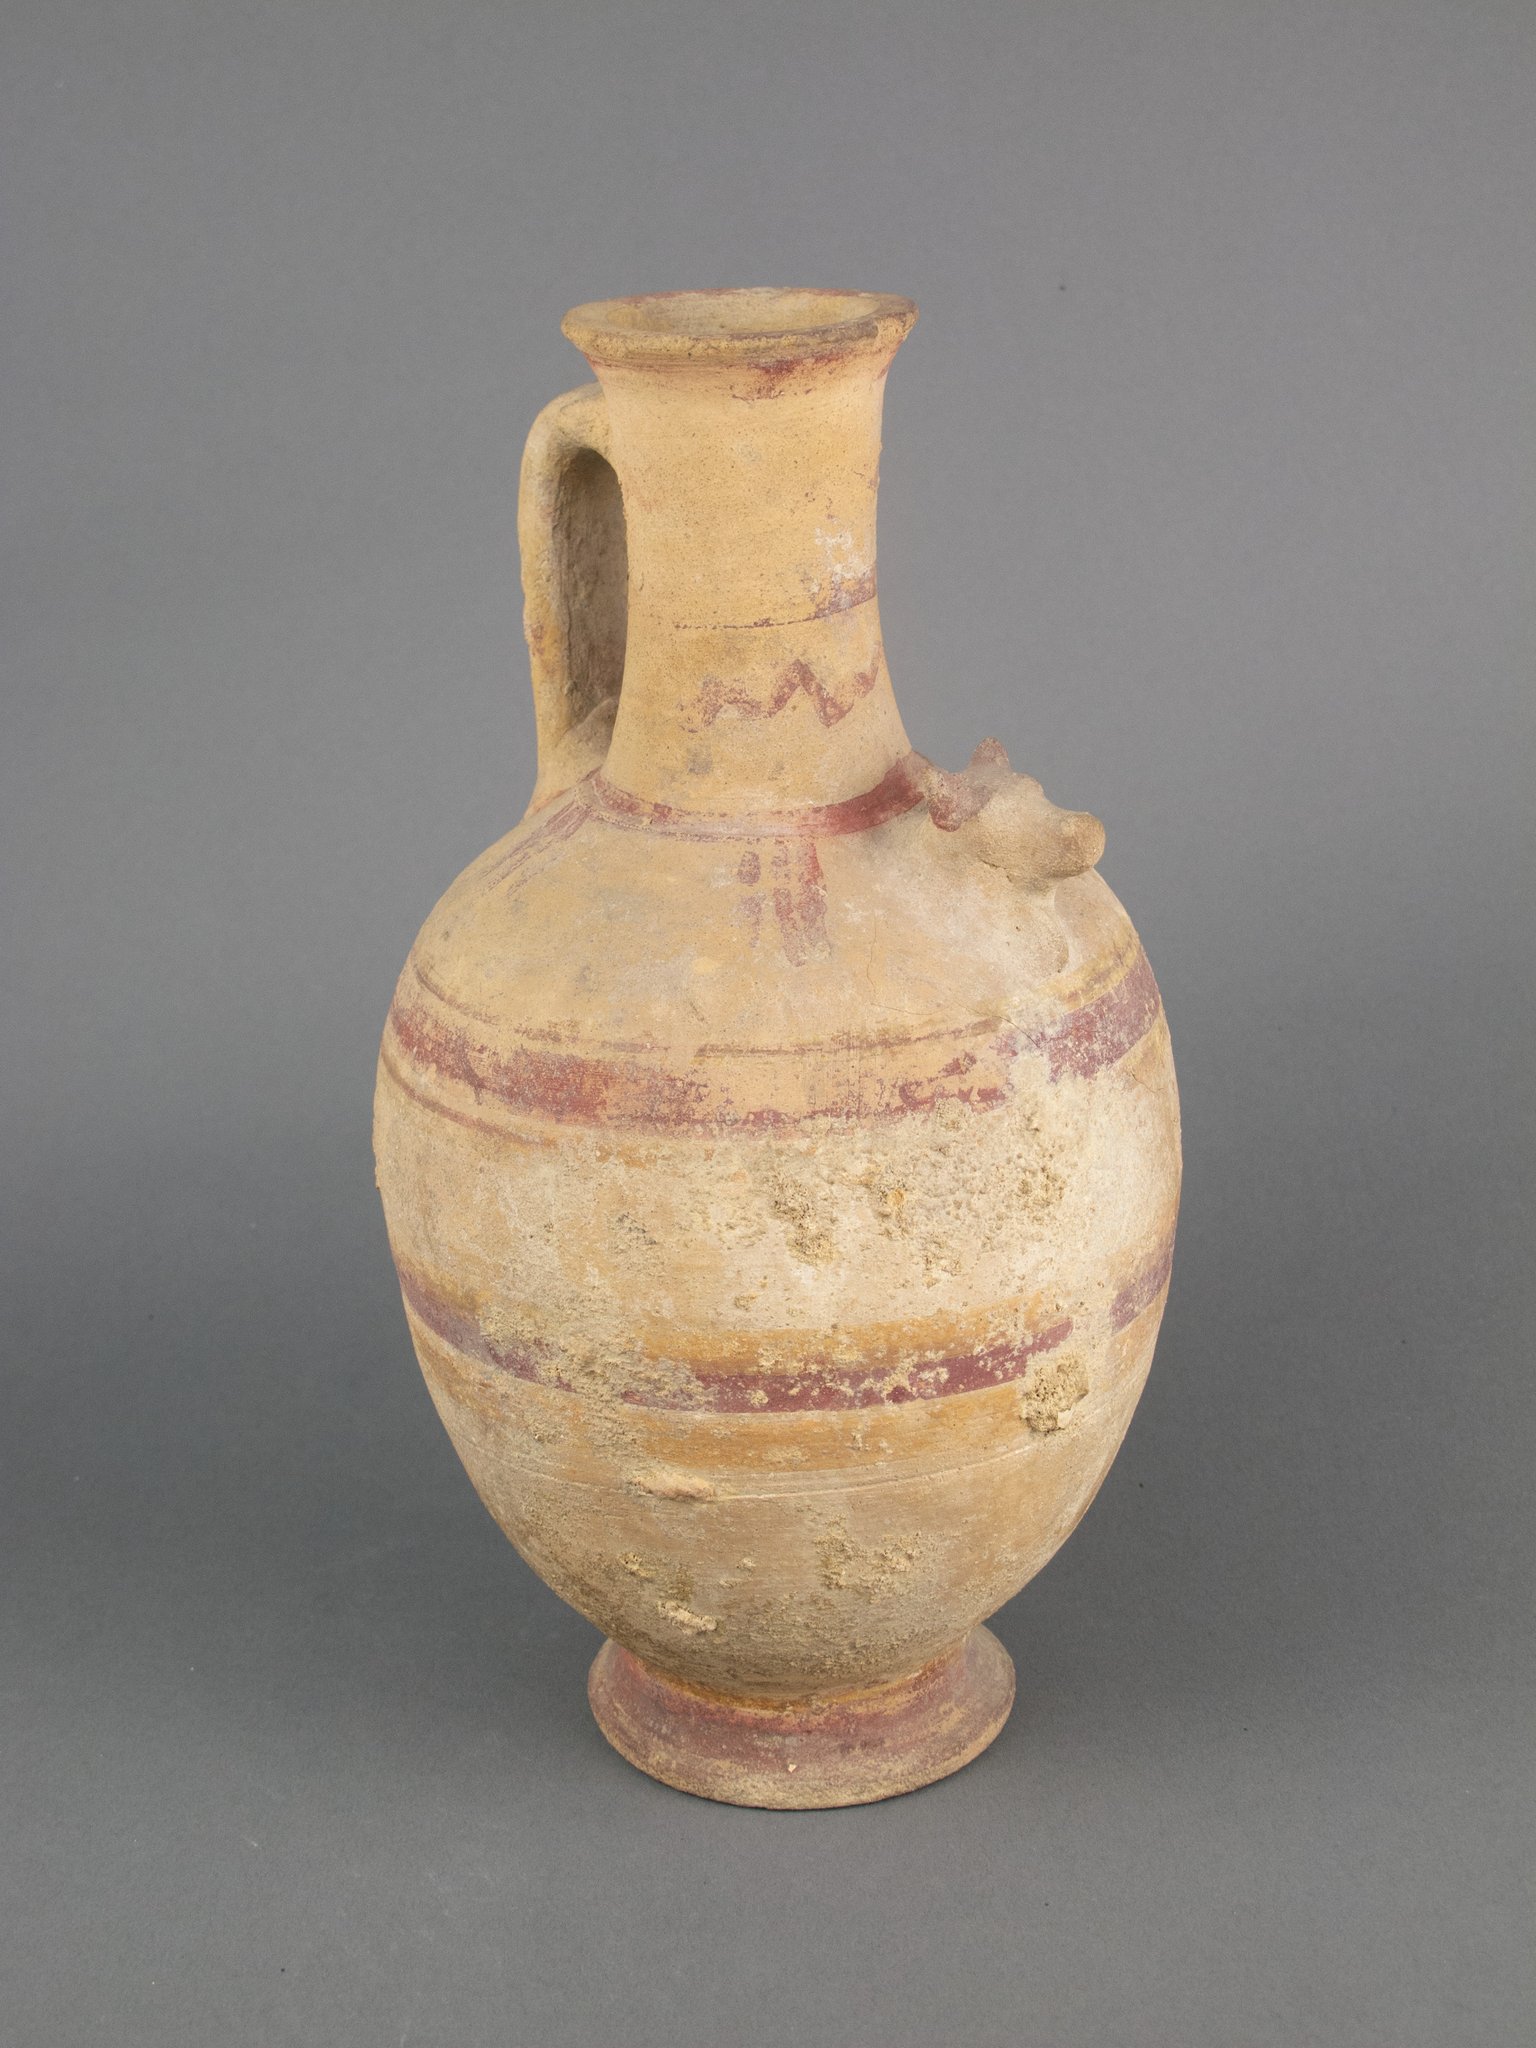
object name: jug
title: Terracotta jug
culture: cypriot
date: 3900 BCE-100 CE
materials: terracotta